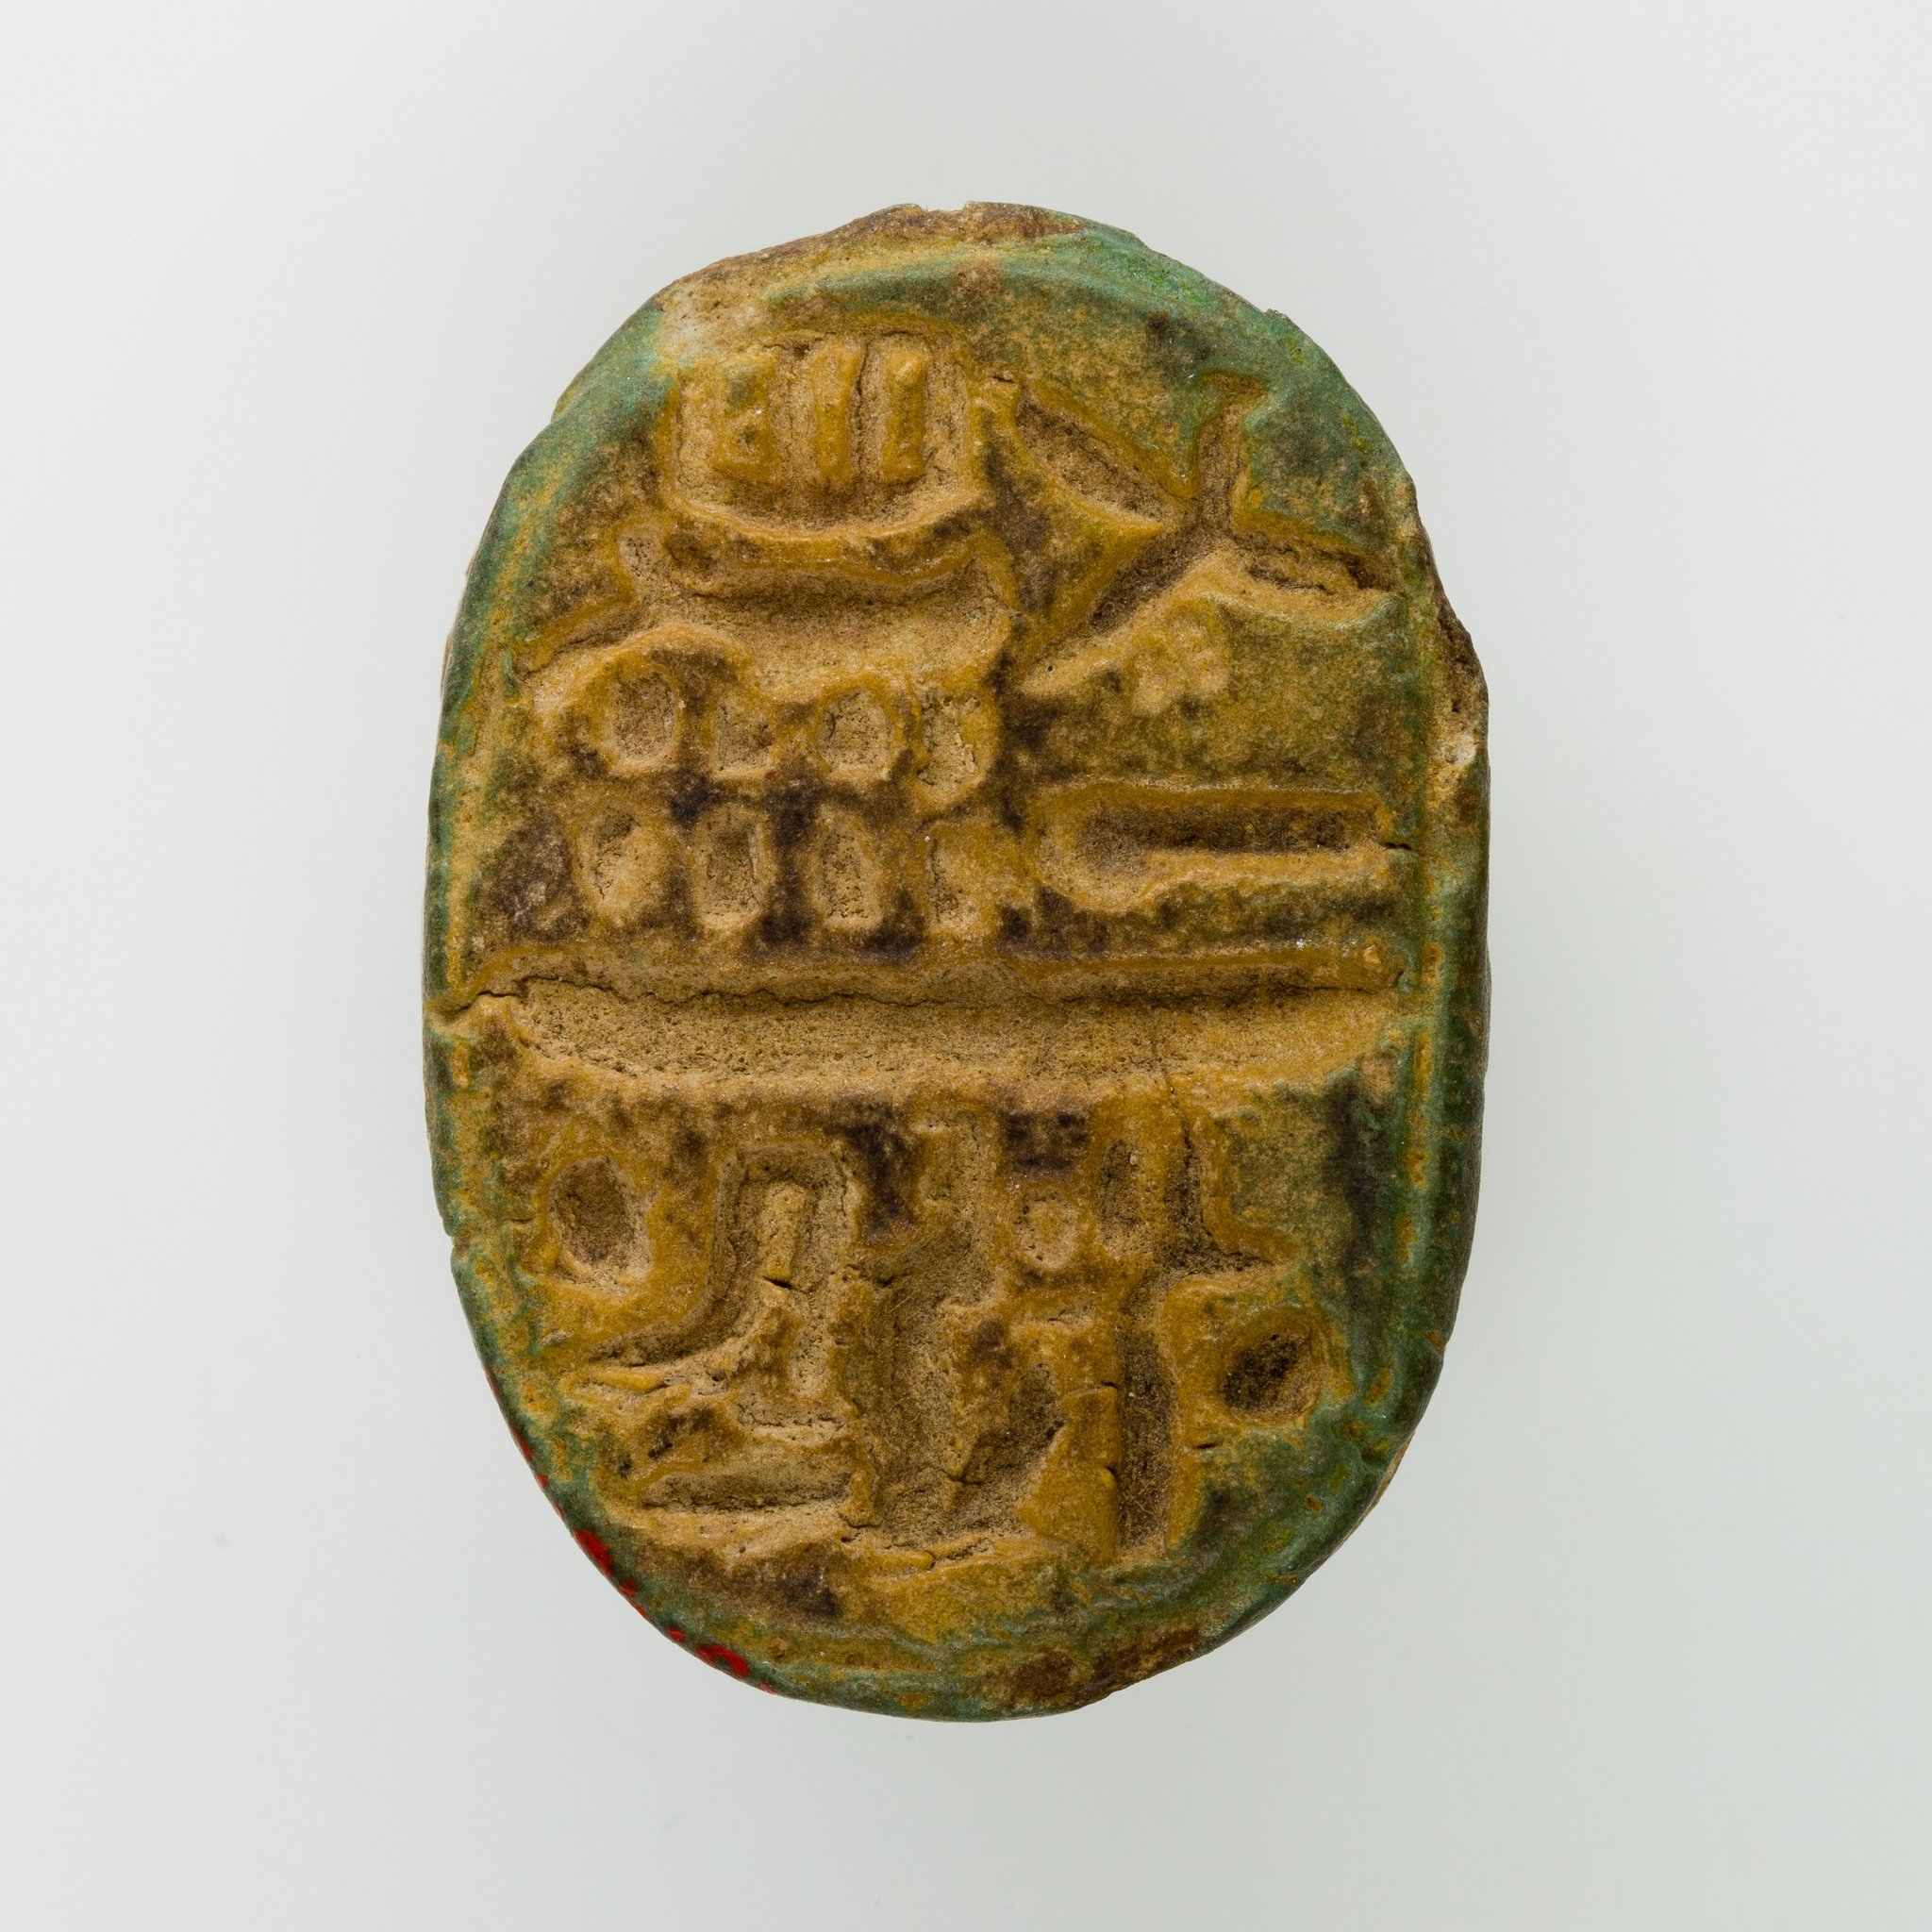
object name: scarab, ramesses ii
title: Scarab of Ramesses II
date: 1295-1070 BCE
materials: faience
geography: egypt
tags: hieroglyphs,scarabs